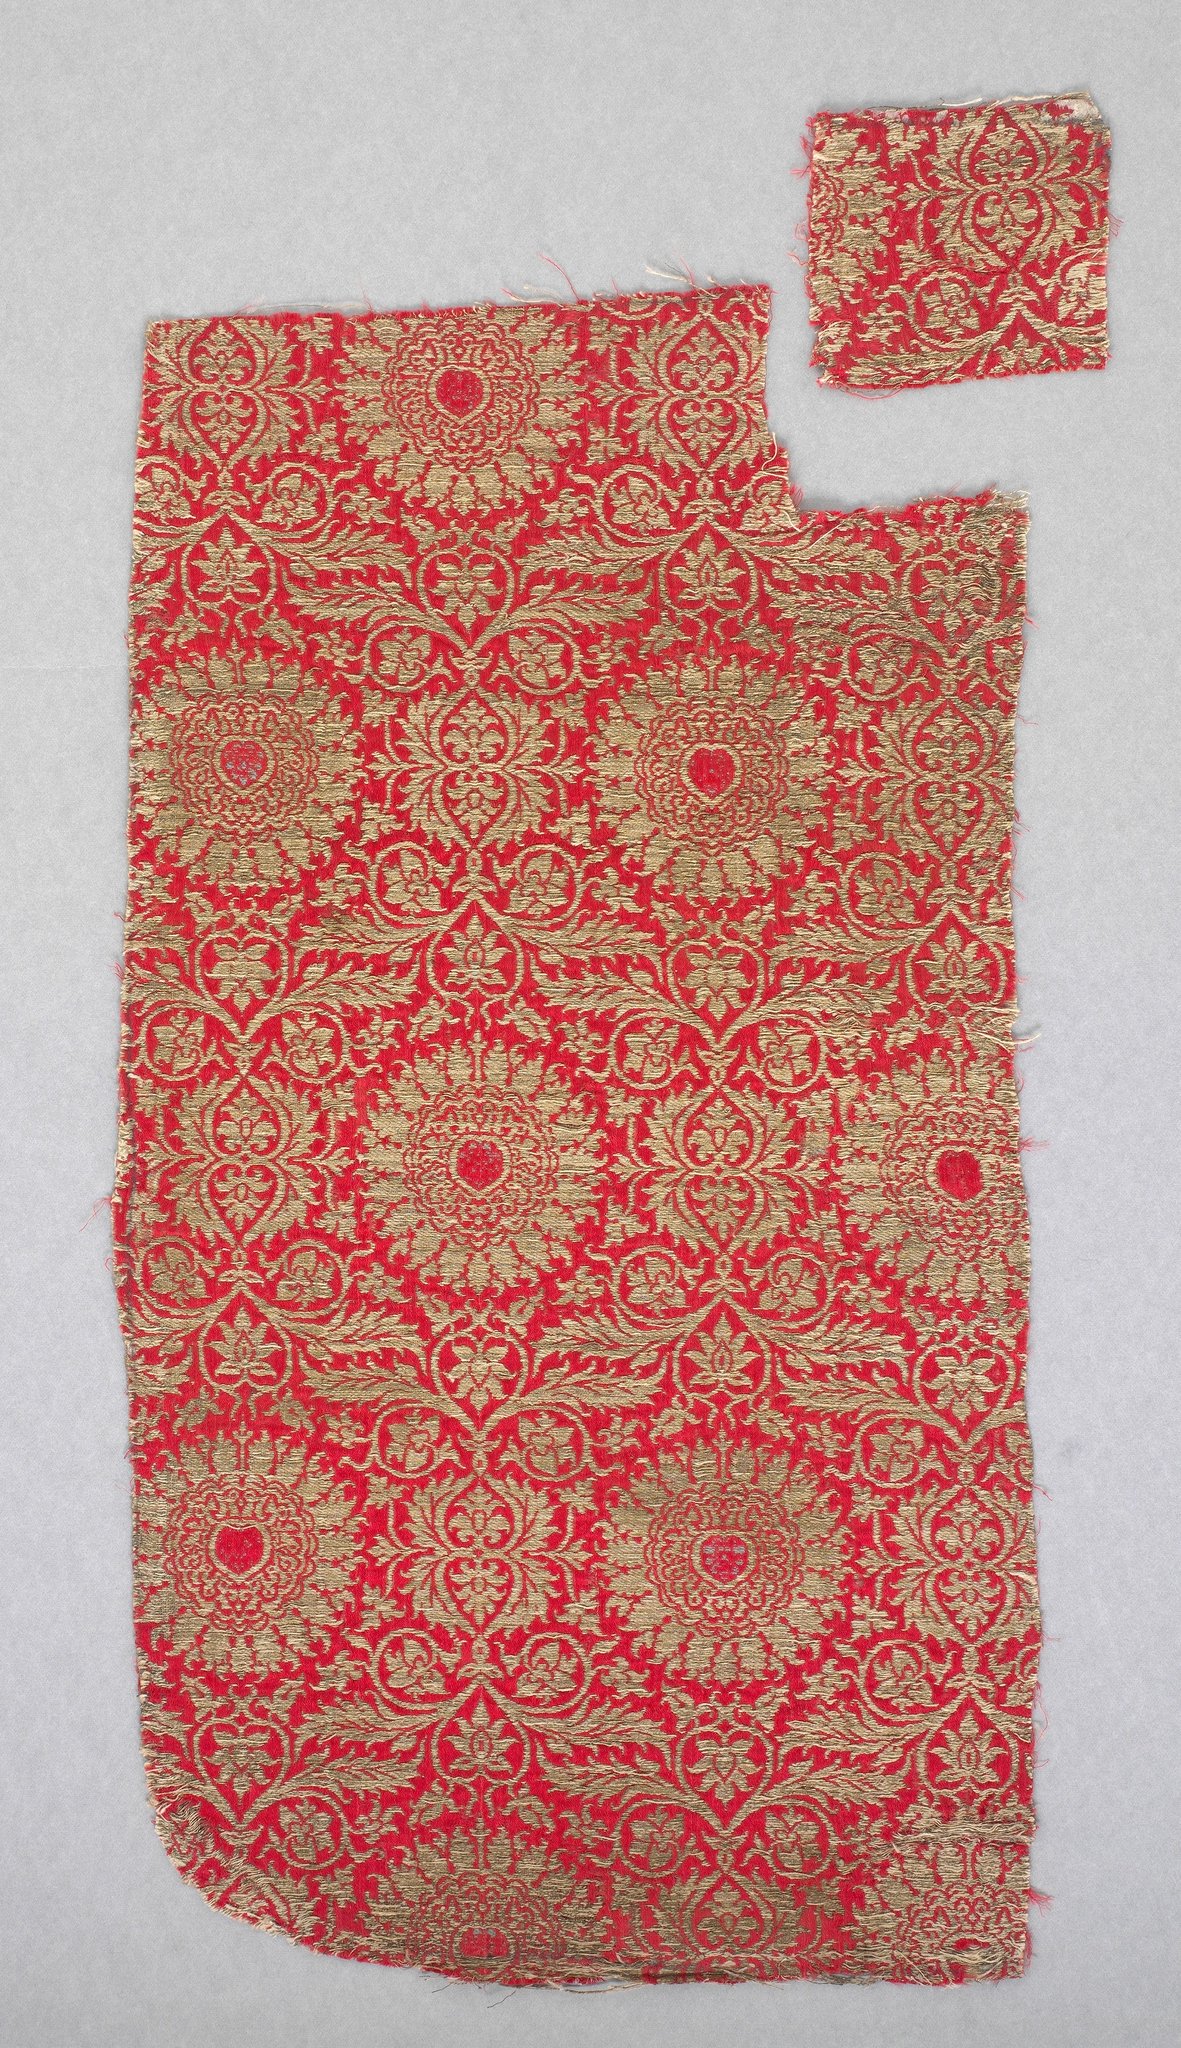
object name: textile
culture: italian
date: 1301-1400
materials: metal thread, silk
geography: italy